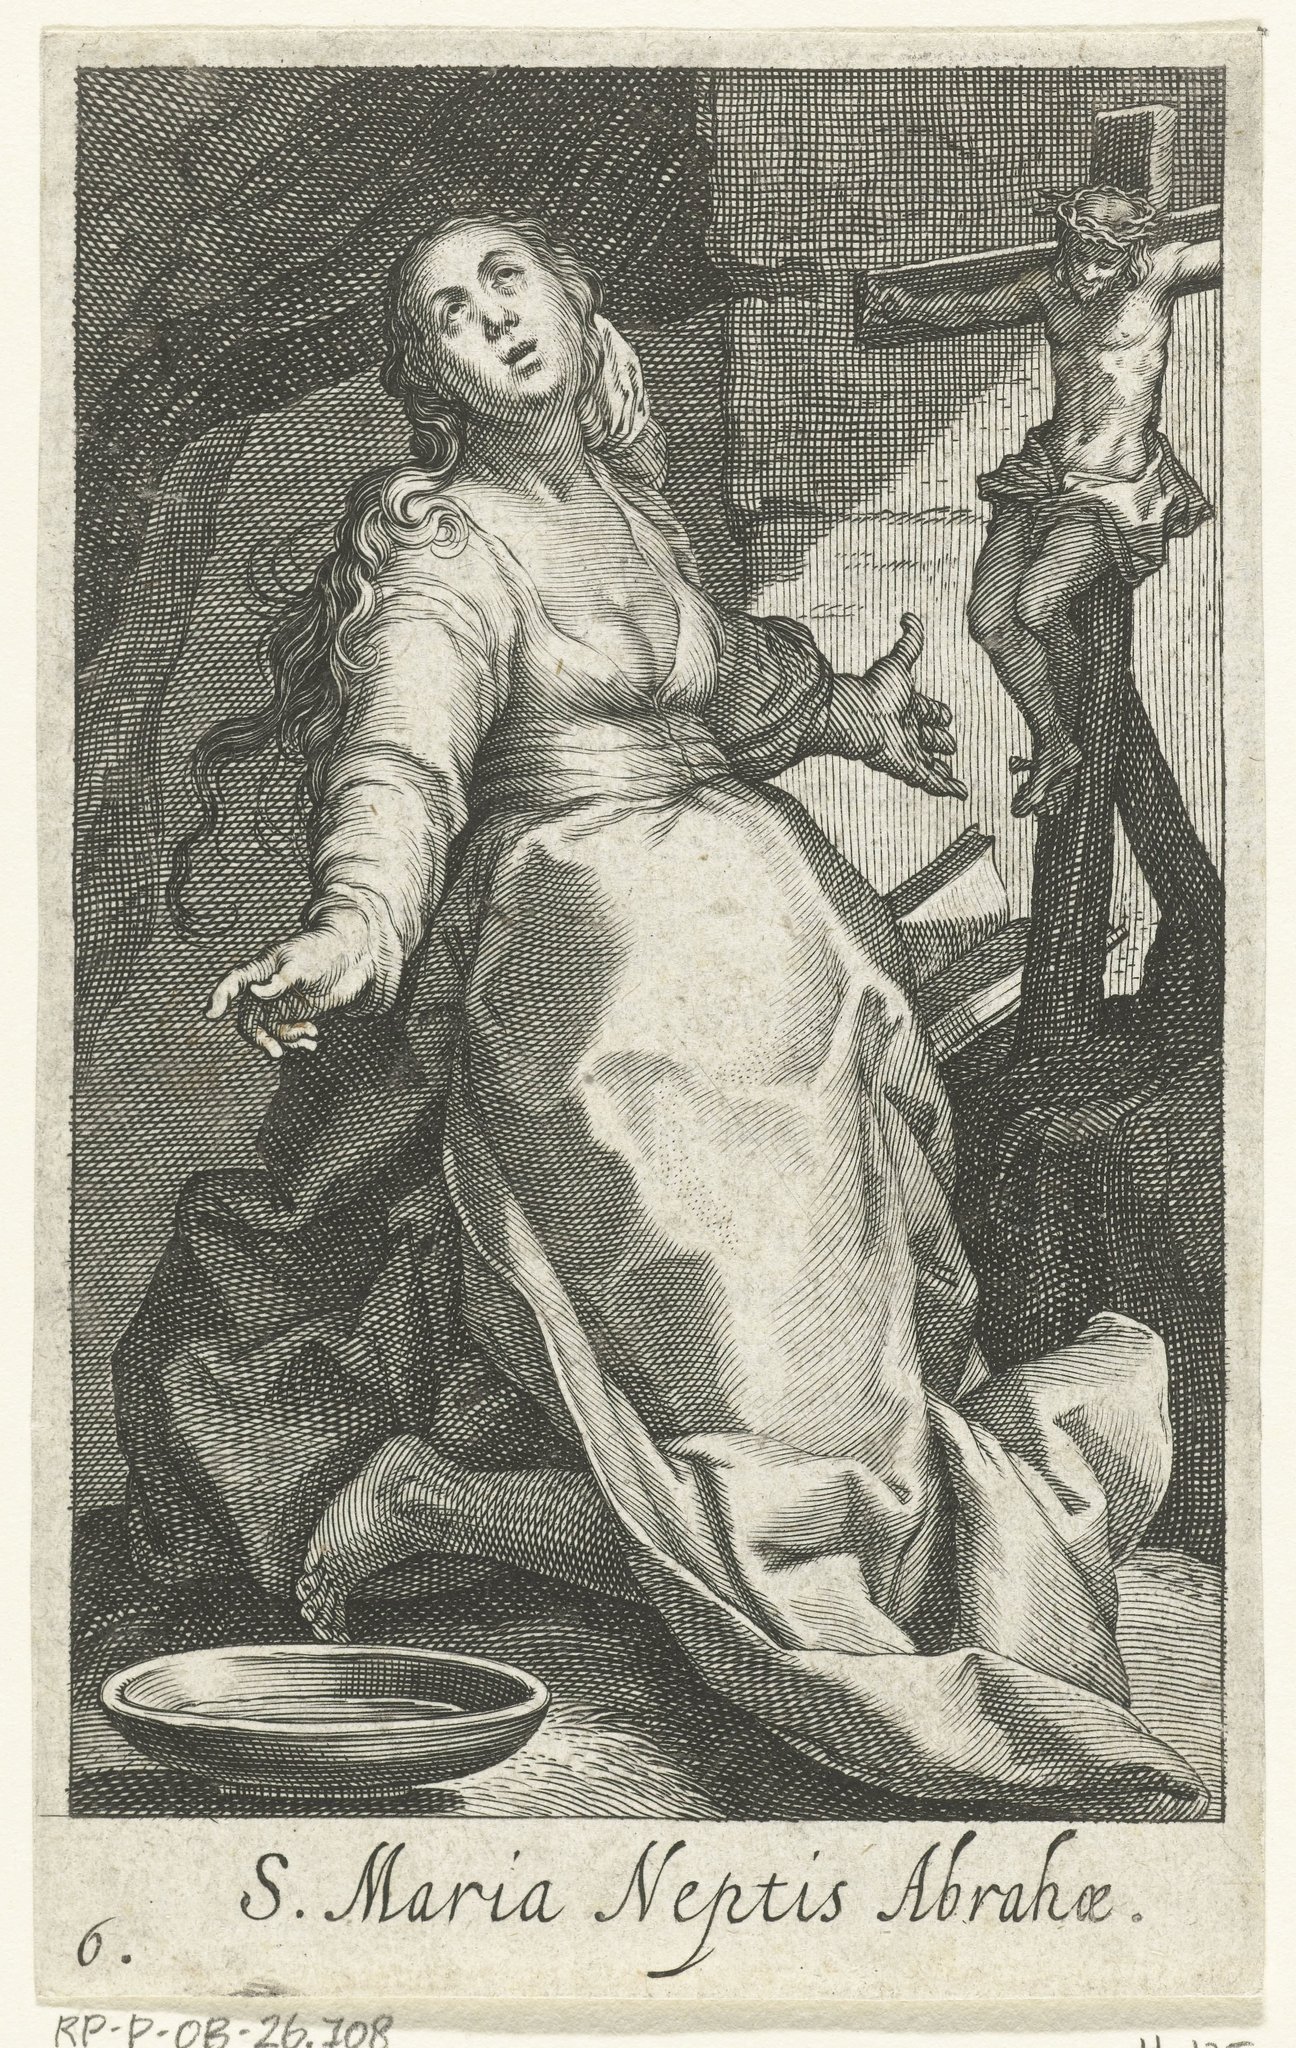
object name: print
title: Kluizenaressen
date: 1590-1612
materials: paper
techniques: engraving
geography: amsterdam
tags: anchorite, hermit, female saints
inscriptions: collector's mark: Lugt 2228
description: Prent uit: Sacra Eremus Ascetriarum, Hendrik Aertssen, Antwerpen 1619. Prent uit de serie van vijfentwintig kluizenaressen in deze uitgave. In 1612 verscheen de ongebonden editie maar op basis van de gewijzigde opschriften en samenstelling van de serie kluizenaars wordt aangenomen dat de prenten van de uitgave 1619 ook in 1612 of iets daarvoor gedrukt werden. De serie kluizenaressen bleef vrijwel ongewijzigd in de ongebonden uitgave van 1612, dit compliceert de datering van de losse bladen in de collectie van het RMA, zie Roethlisberger 1993, p. 171-175. Door de aanwezigheid van Franse tekst op het verso kunnen we vaststellen dat dit blad afkomstig is uit de Antwerpse uitgave van 1619.